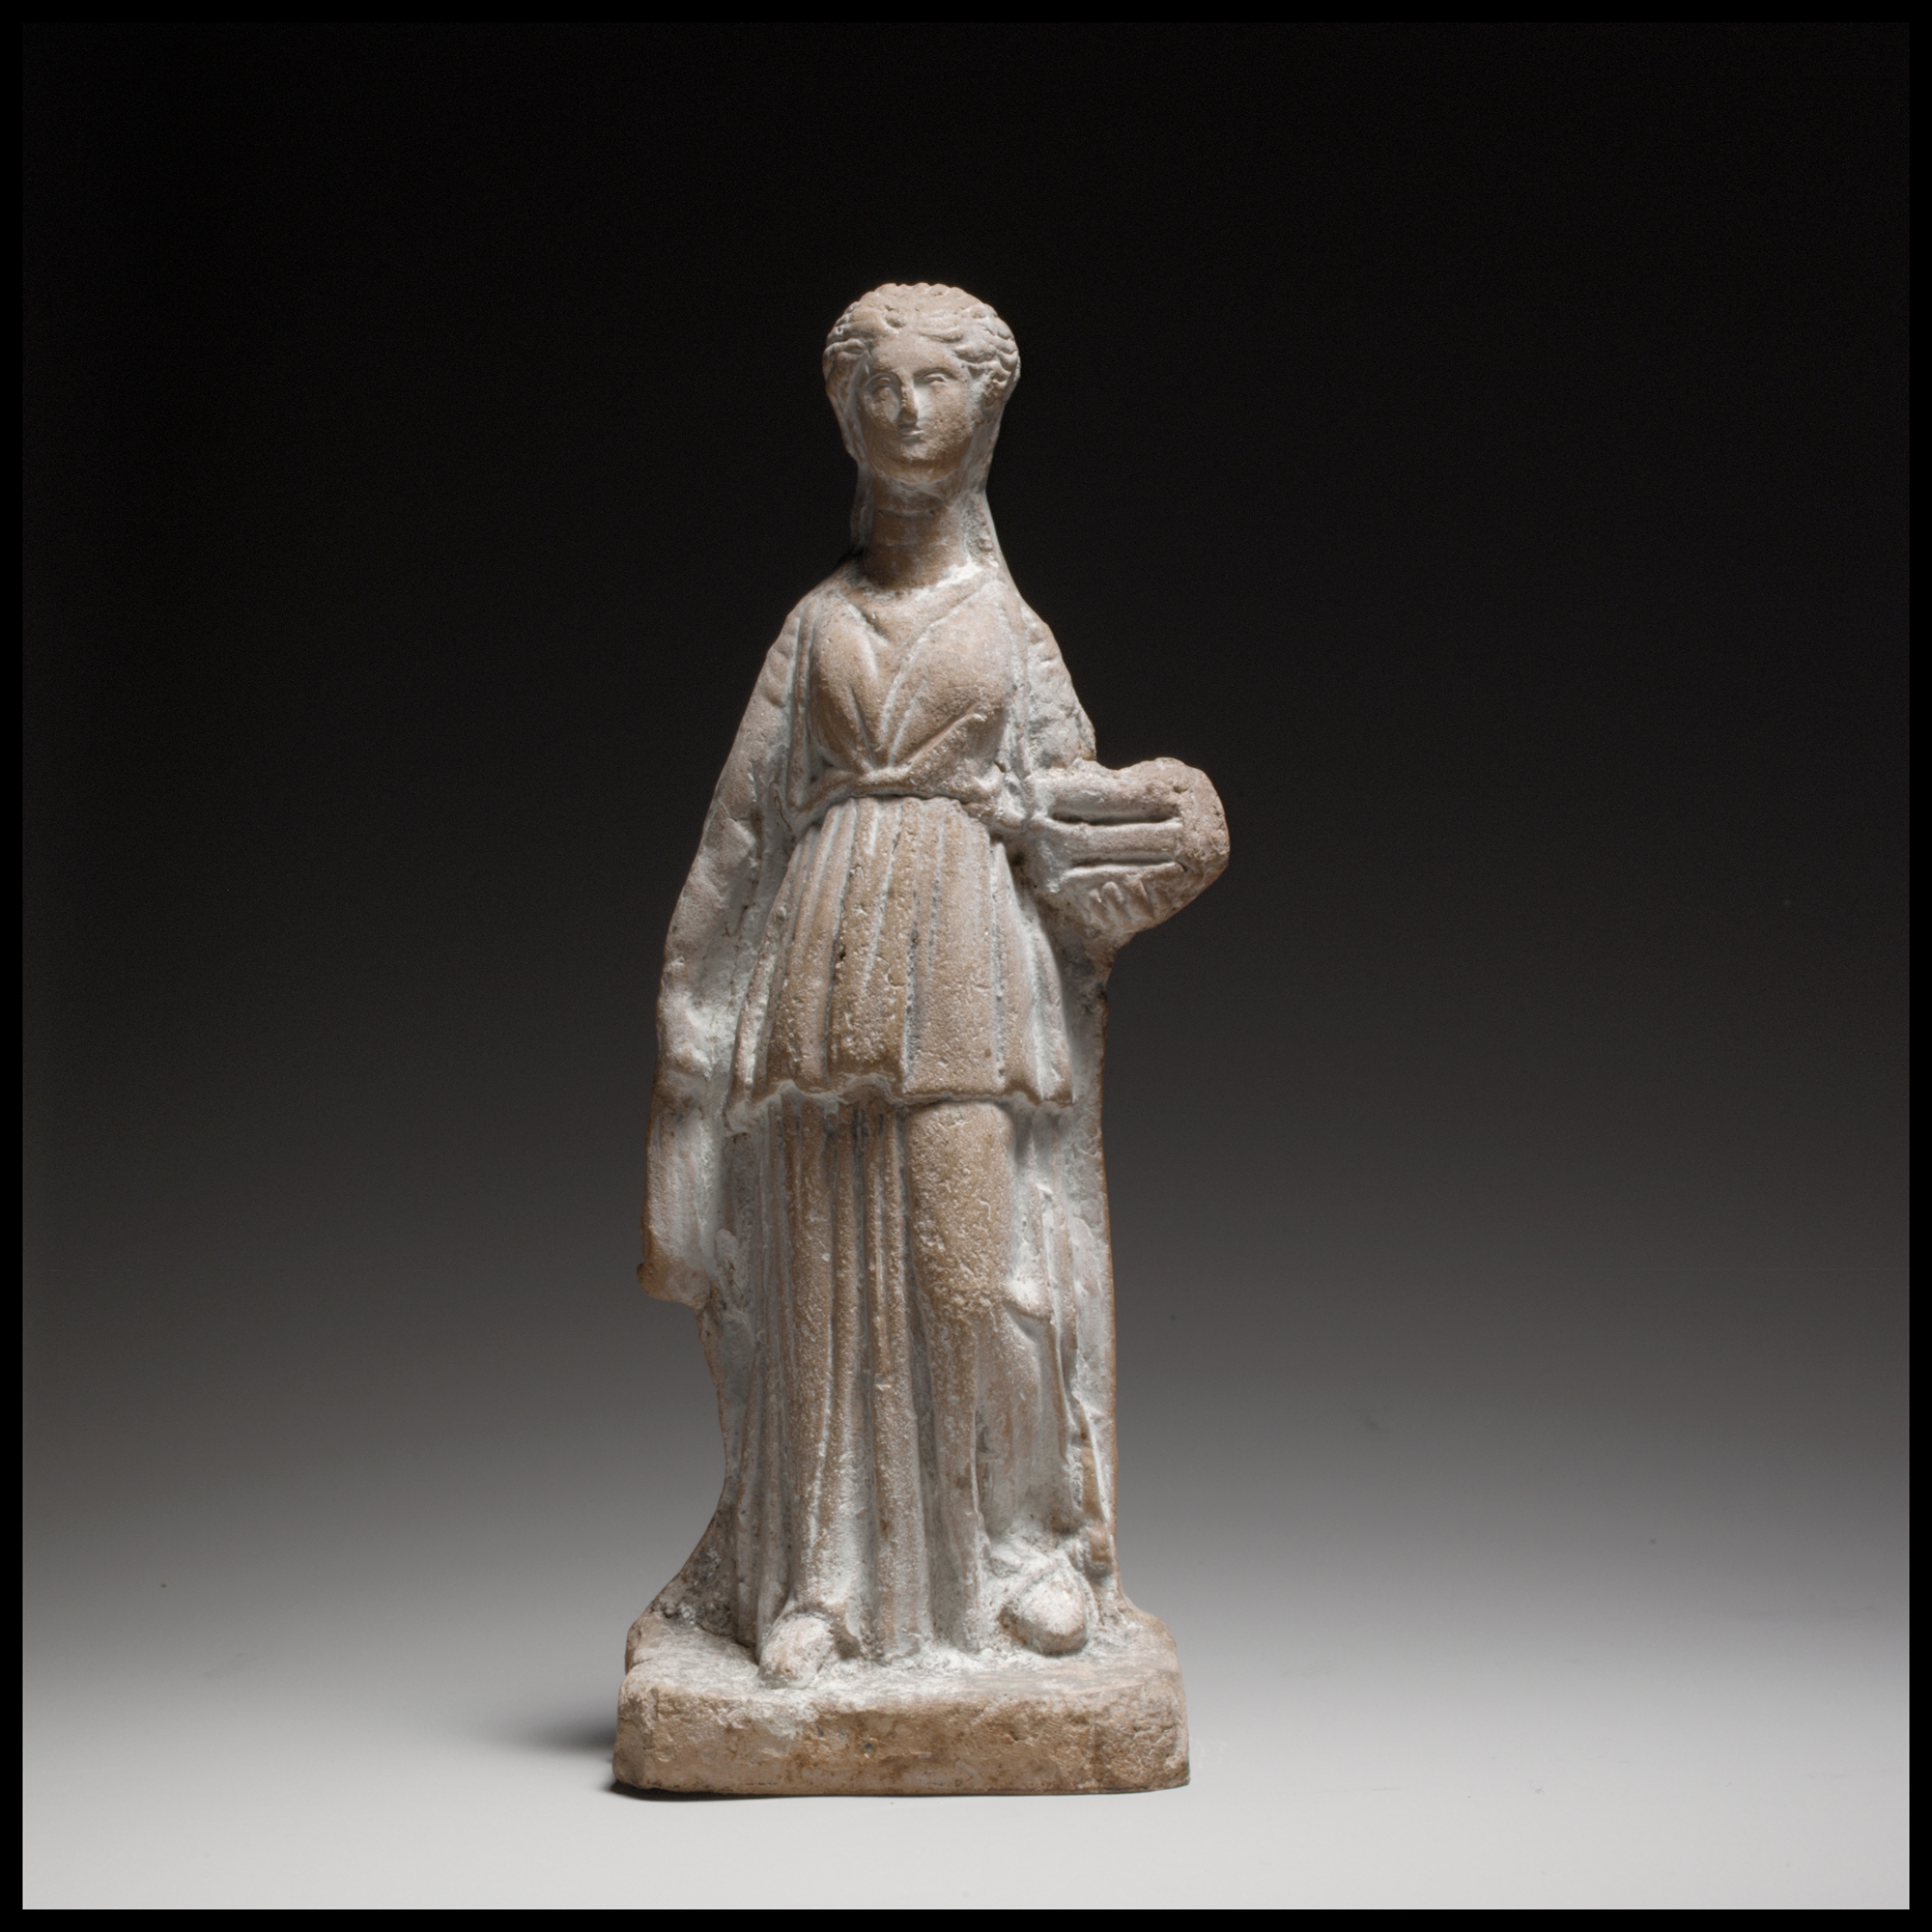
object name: figurine of a female votary holding a box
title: Terracotta figuring of a standing female votary holding a box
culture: cypriot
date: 300 BCE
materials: terracotta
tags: women